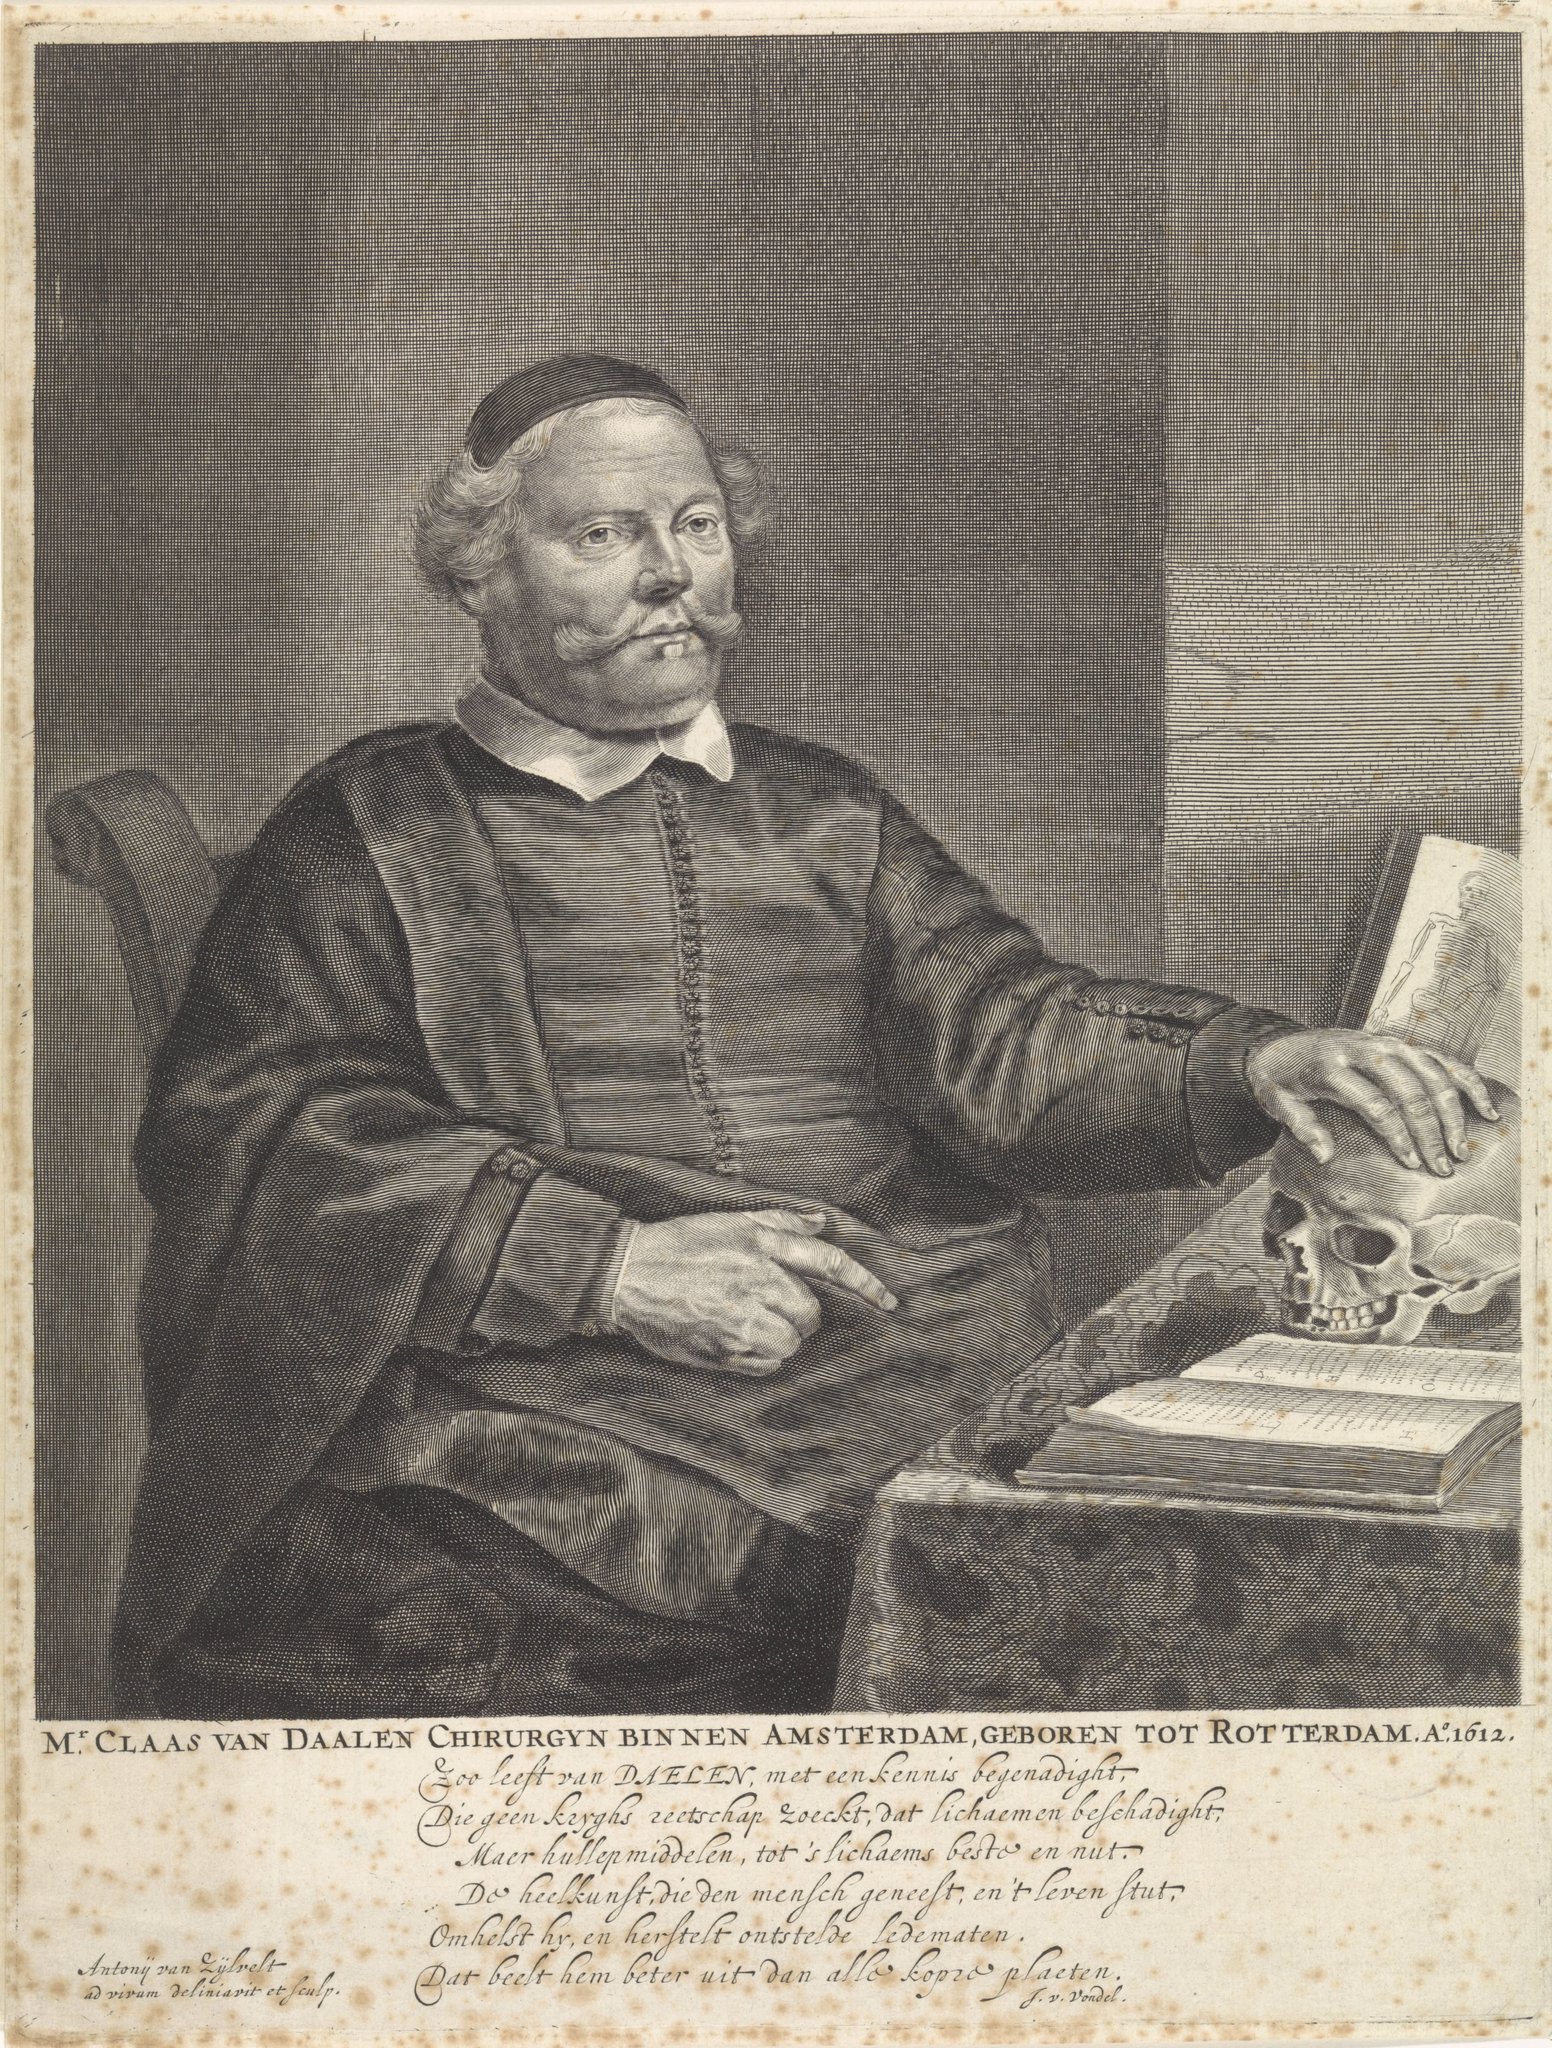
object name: print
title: Portret van Nicolaas van Daalen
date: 1654-1658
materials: paper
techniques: engraving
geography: amsterdam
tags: chirurg, nicolaas van daalen (chirurg)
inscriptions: collector's mark: Lugt 240, poem: ‘Zoo leeft van Daelen met een kennis begenadight / Die geen kryghs reetschap zoeckt, dat lichaemen beschadight / Maer hullep middelen, tot 's lichaems beste en nut / De heelkunst, die den mensch geneest, en 't leven stut / Omhelst hy, en herstelt ontstelde ledematen / Dat beelt hem beter uit dan alle kooper plaeten’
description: Portret van Nicolaas van Daalen, chirurg te Amsterdam, zittend bij een tafel waarop anatomieboeken en een schedel liggen. Onderaan in de marge een zesregelig gedicht van Vondel.